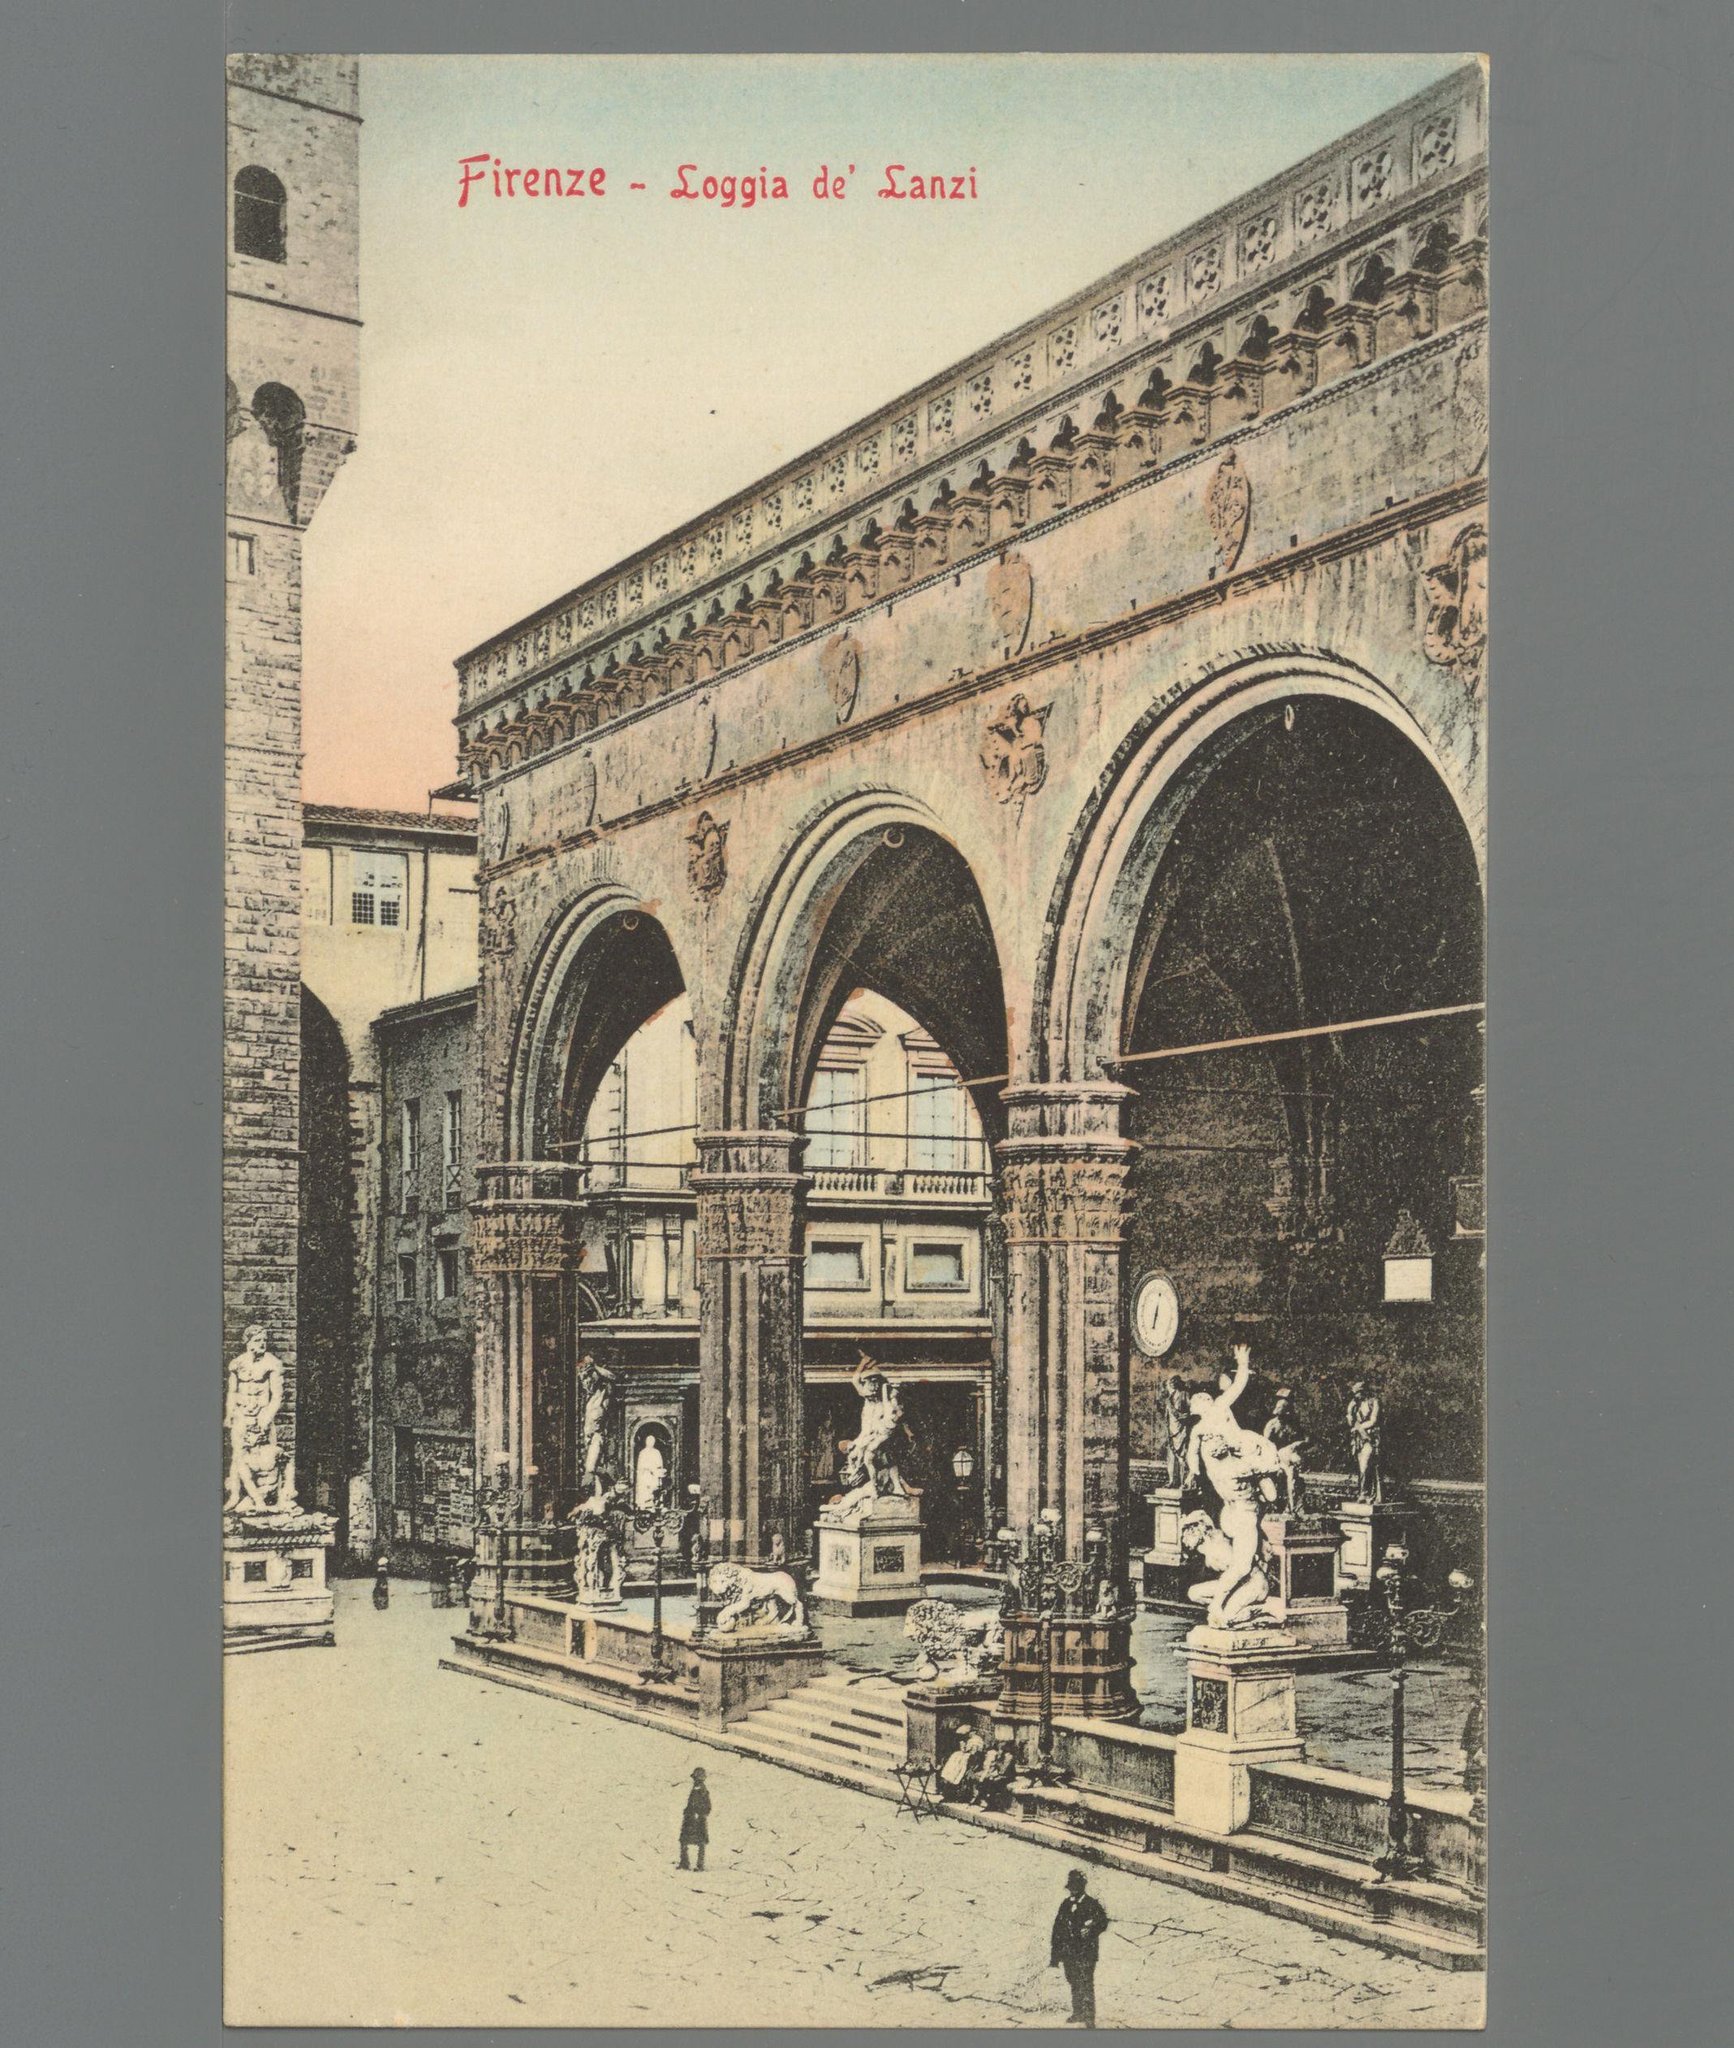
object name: ansichtkaart, prentbriefkaart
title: Firenze. Loggia de' Lanzi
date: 1905-1930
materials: cardboard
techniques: photograph, lithograph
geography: dresden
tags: sculpture, arcade ~ architecture, square, place, circus, etc. (+ city(-scape) with figures, staffage)